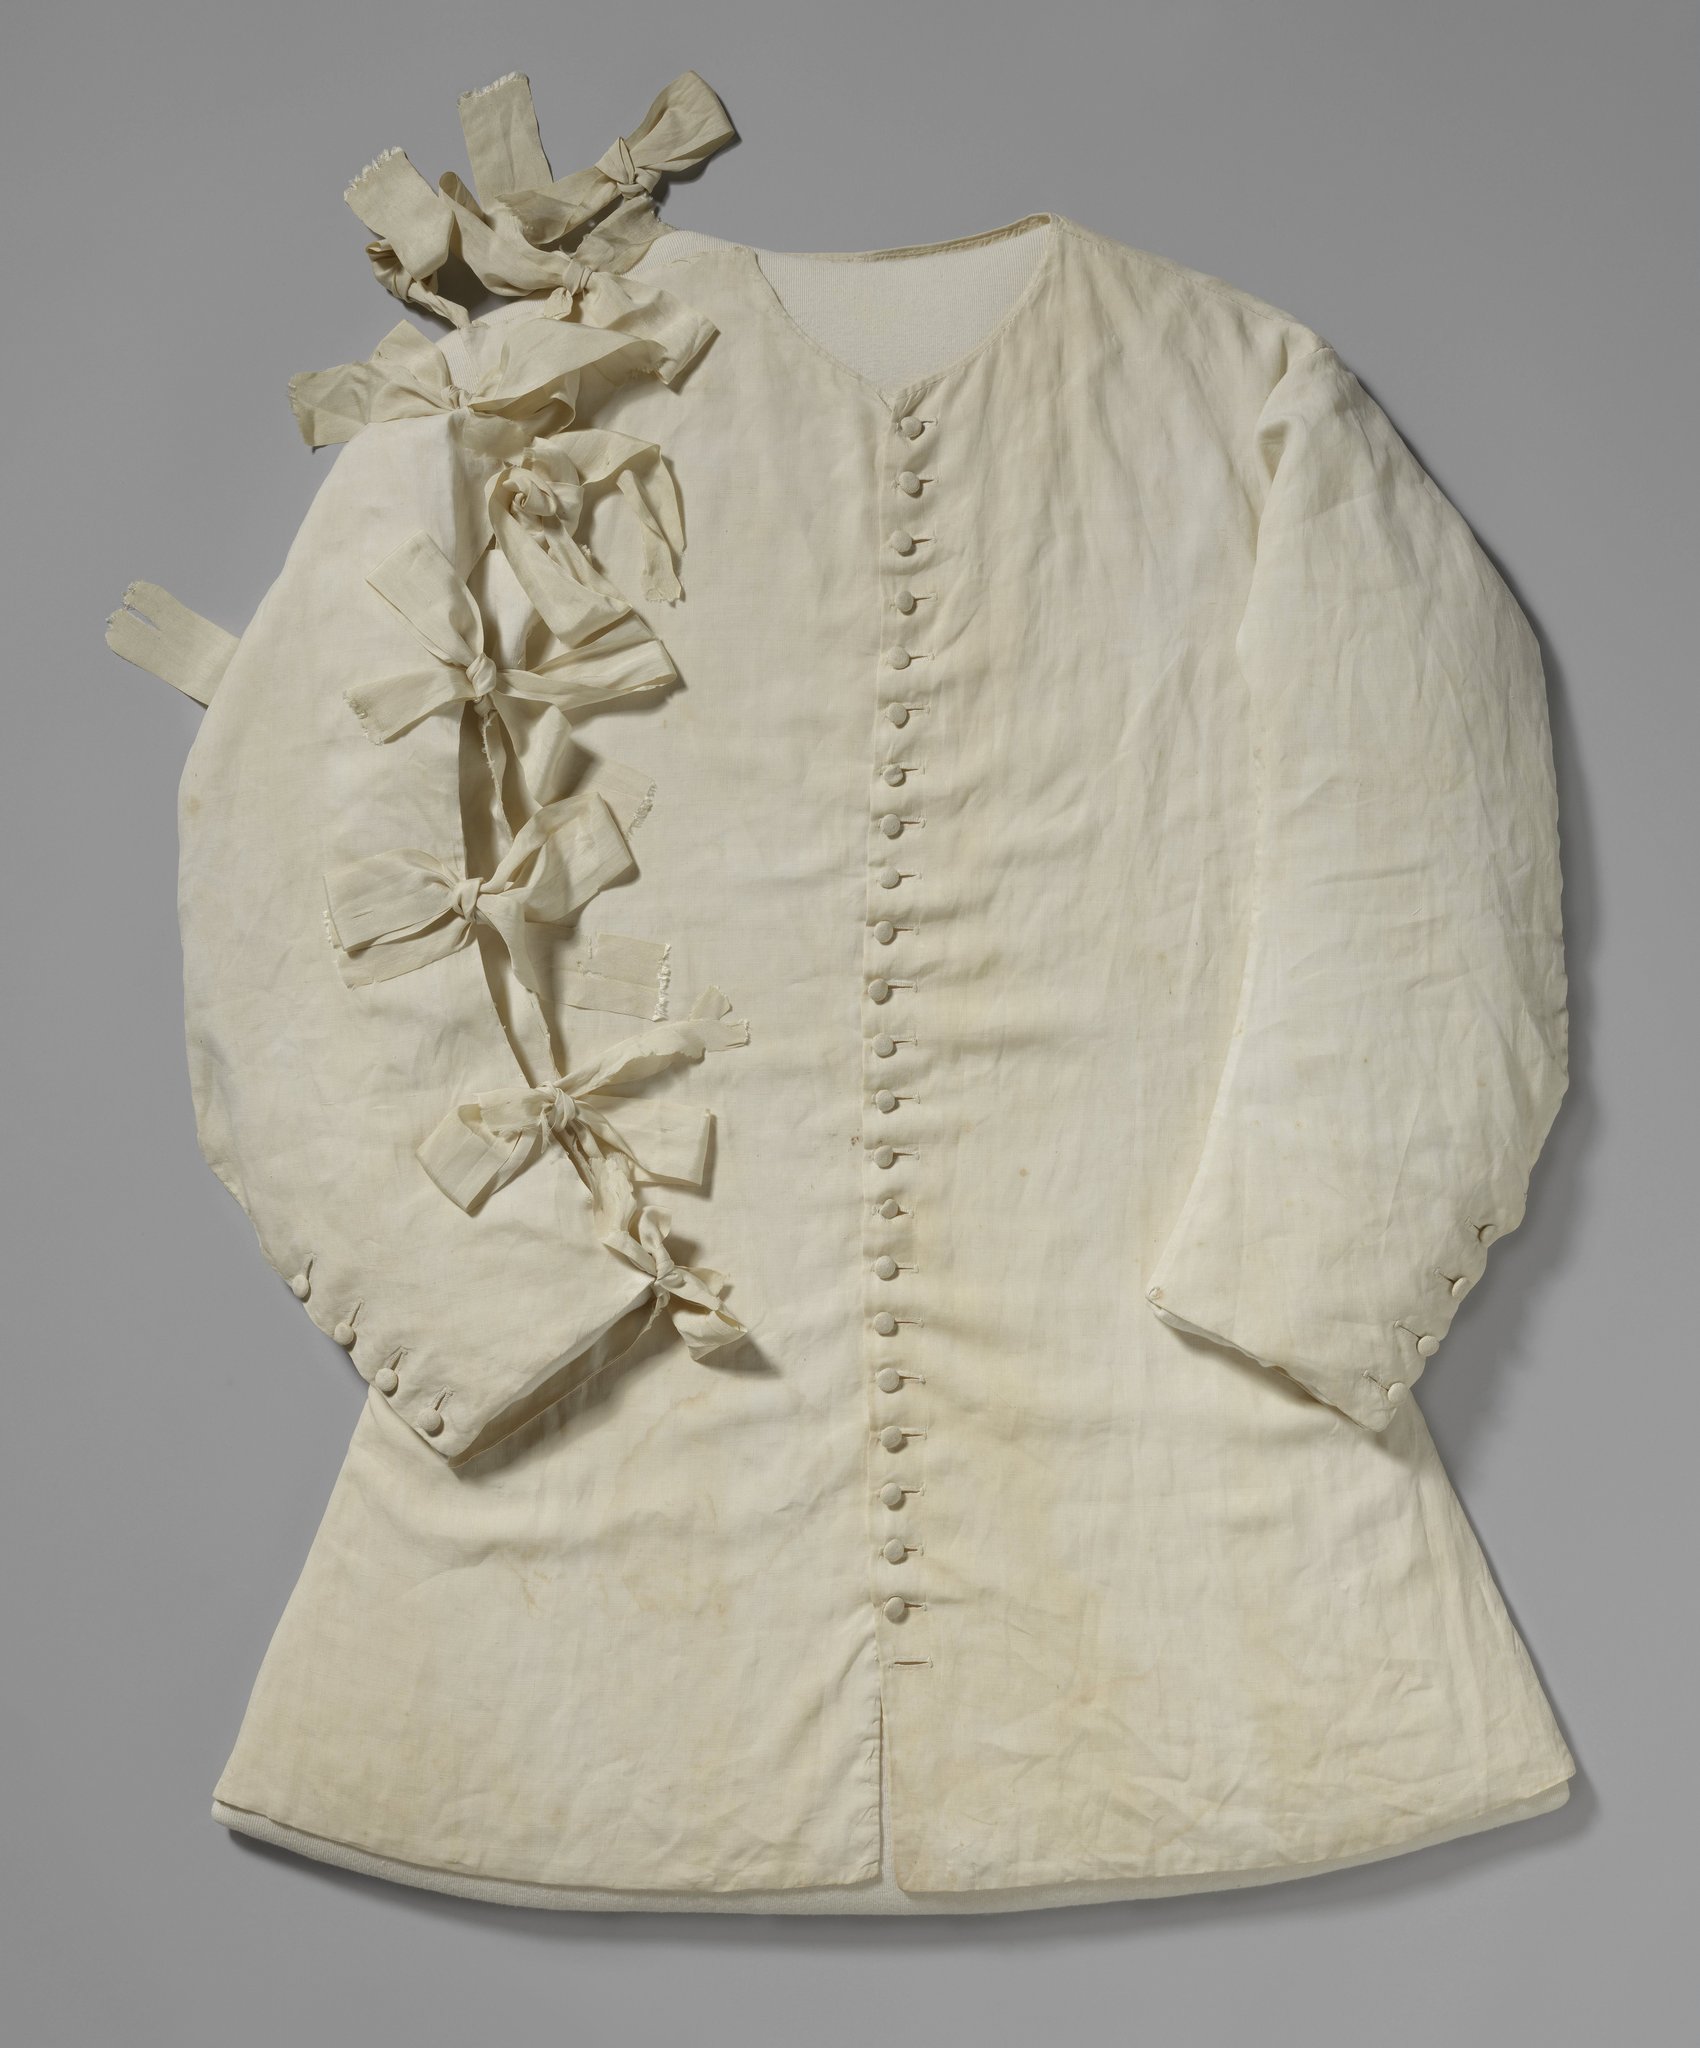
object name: borstrok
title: Sleeved Waistcoat with Bows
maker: Anonymous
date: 1702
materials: linen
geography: england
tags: the hague, william iii (prince of orange and king of england, scotland, and ireland), netherlands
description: Stadholder-King William III fell from his horse at Hampton Court, his English palace, on 4 March 1702 and broke his collarbone. Because of the splint his normal clothing no longer fit. Therefore he wore this adjusted garment: a waistcoat, with an open righthanded sleeve. The waistcoat is fastened with bow ties, but is otherwise undecorated. Despite the good care he received, William’s health failed and he died on 19 March.